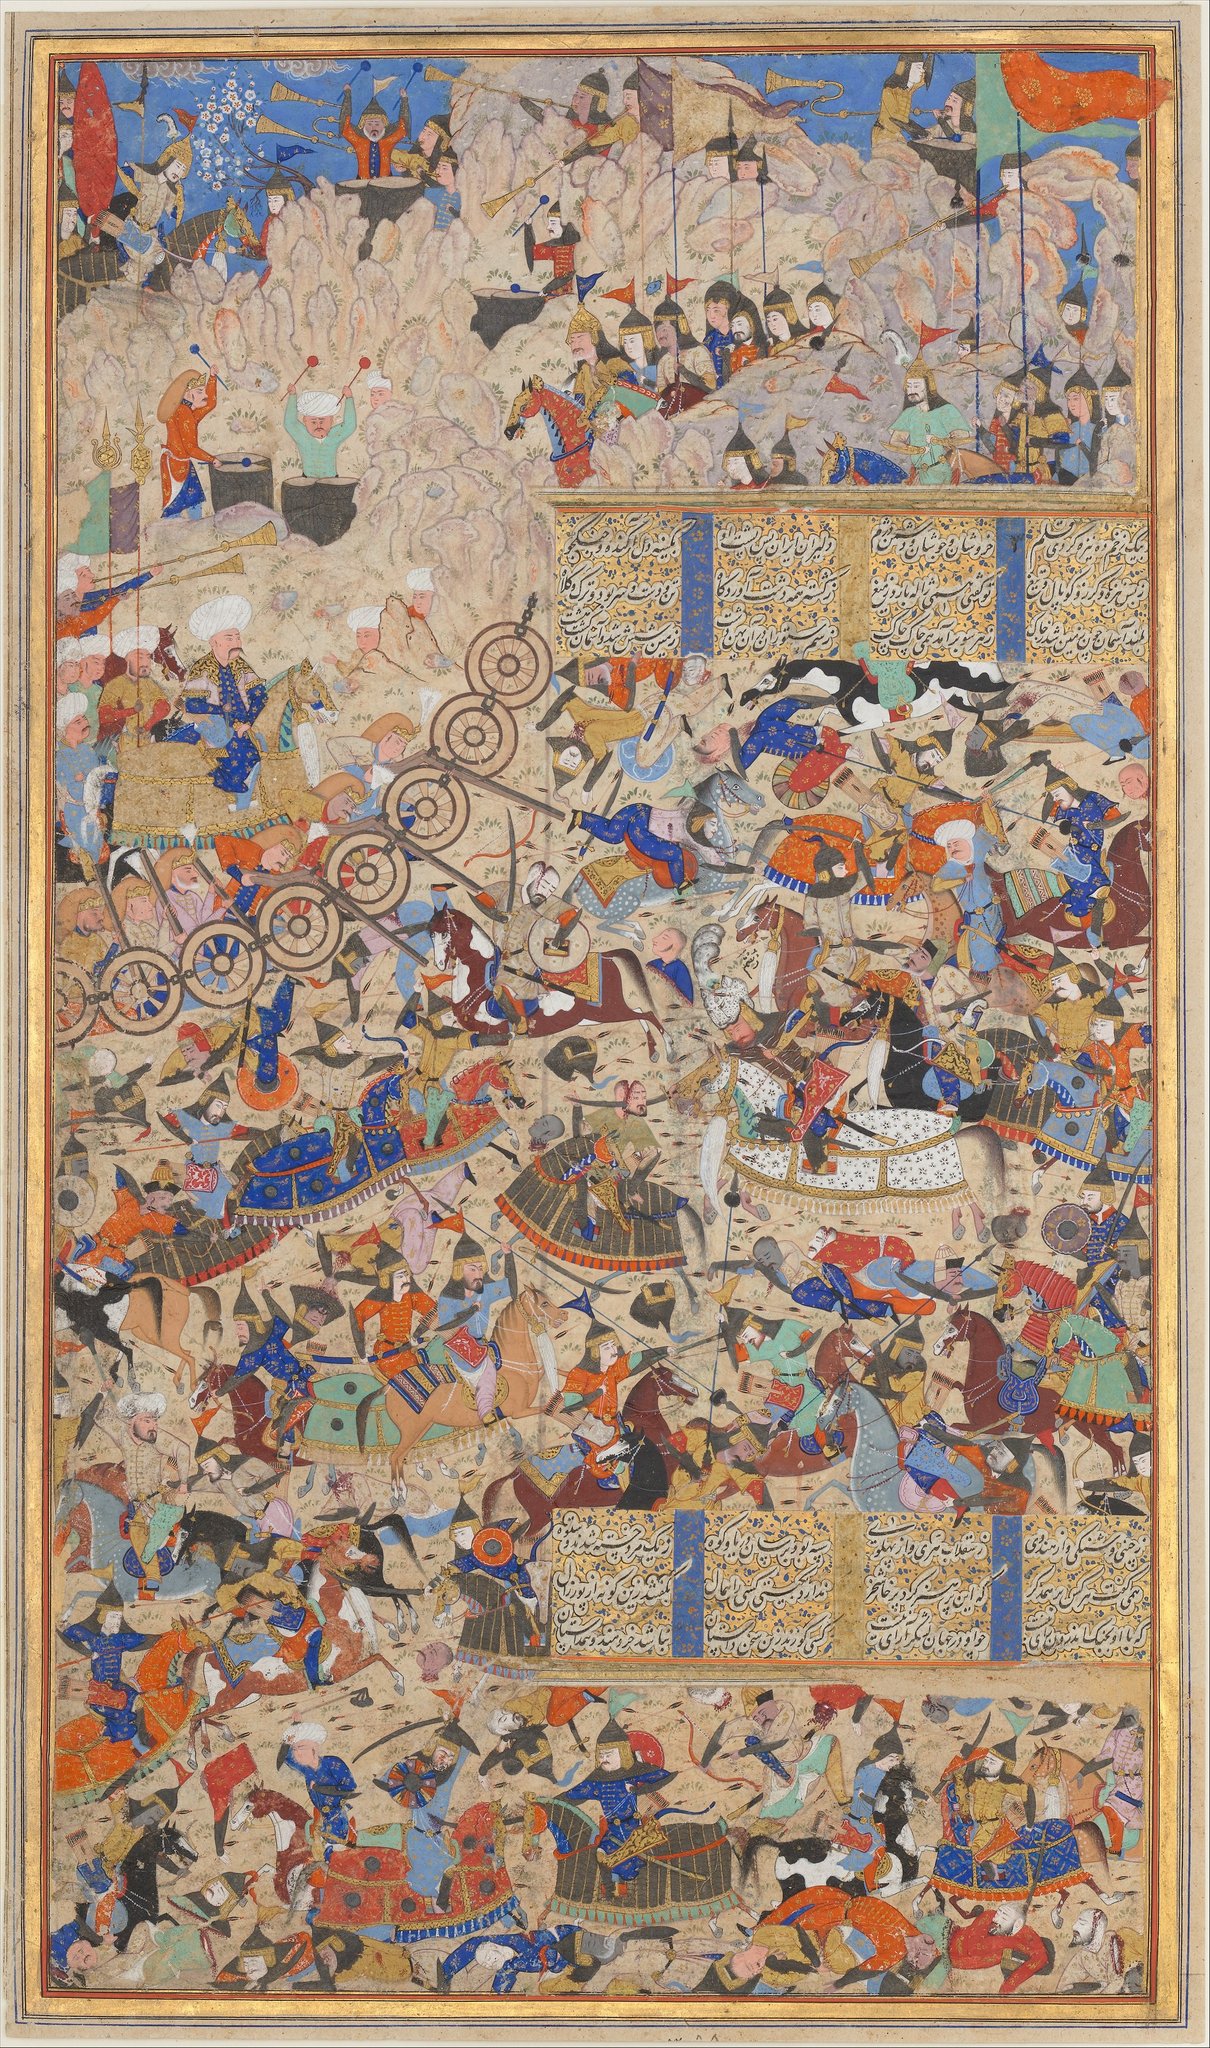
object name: folio from an illustrated manuscript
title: "Battle Between Iranians and Turanians", Folio from a Shahnama (Book of Kings)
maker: muhammad al-qivam al-shirazi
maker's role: calligrapher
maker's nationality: iranian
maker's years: 1535-1585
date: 1562-1583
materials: gold, ink, paper, watercolor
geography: iran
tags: battles,soldiers,weapons,kings,horses